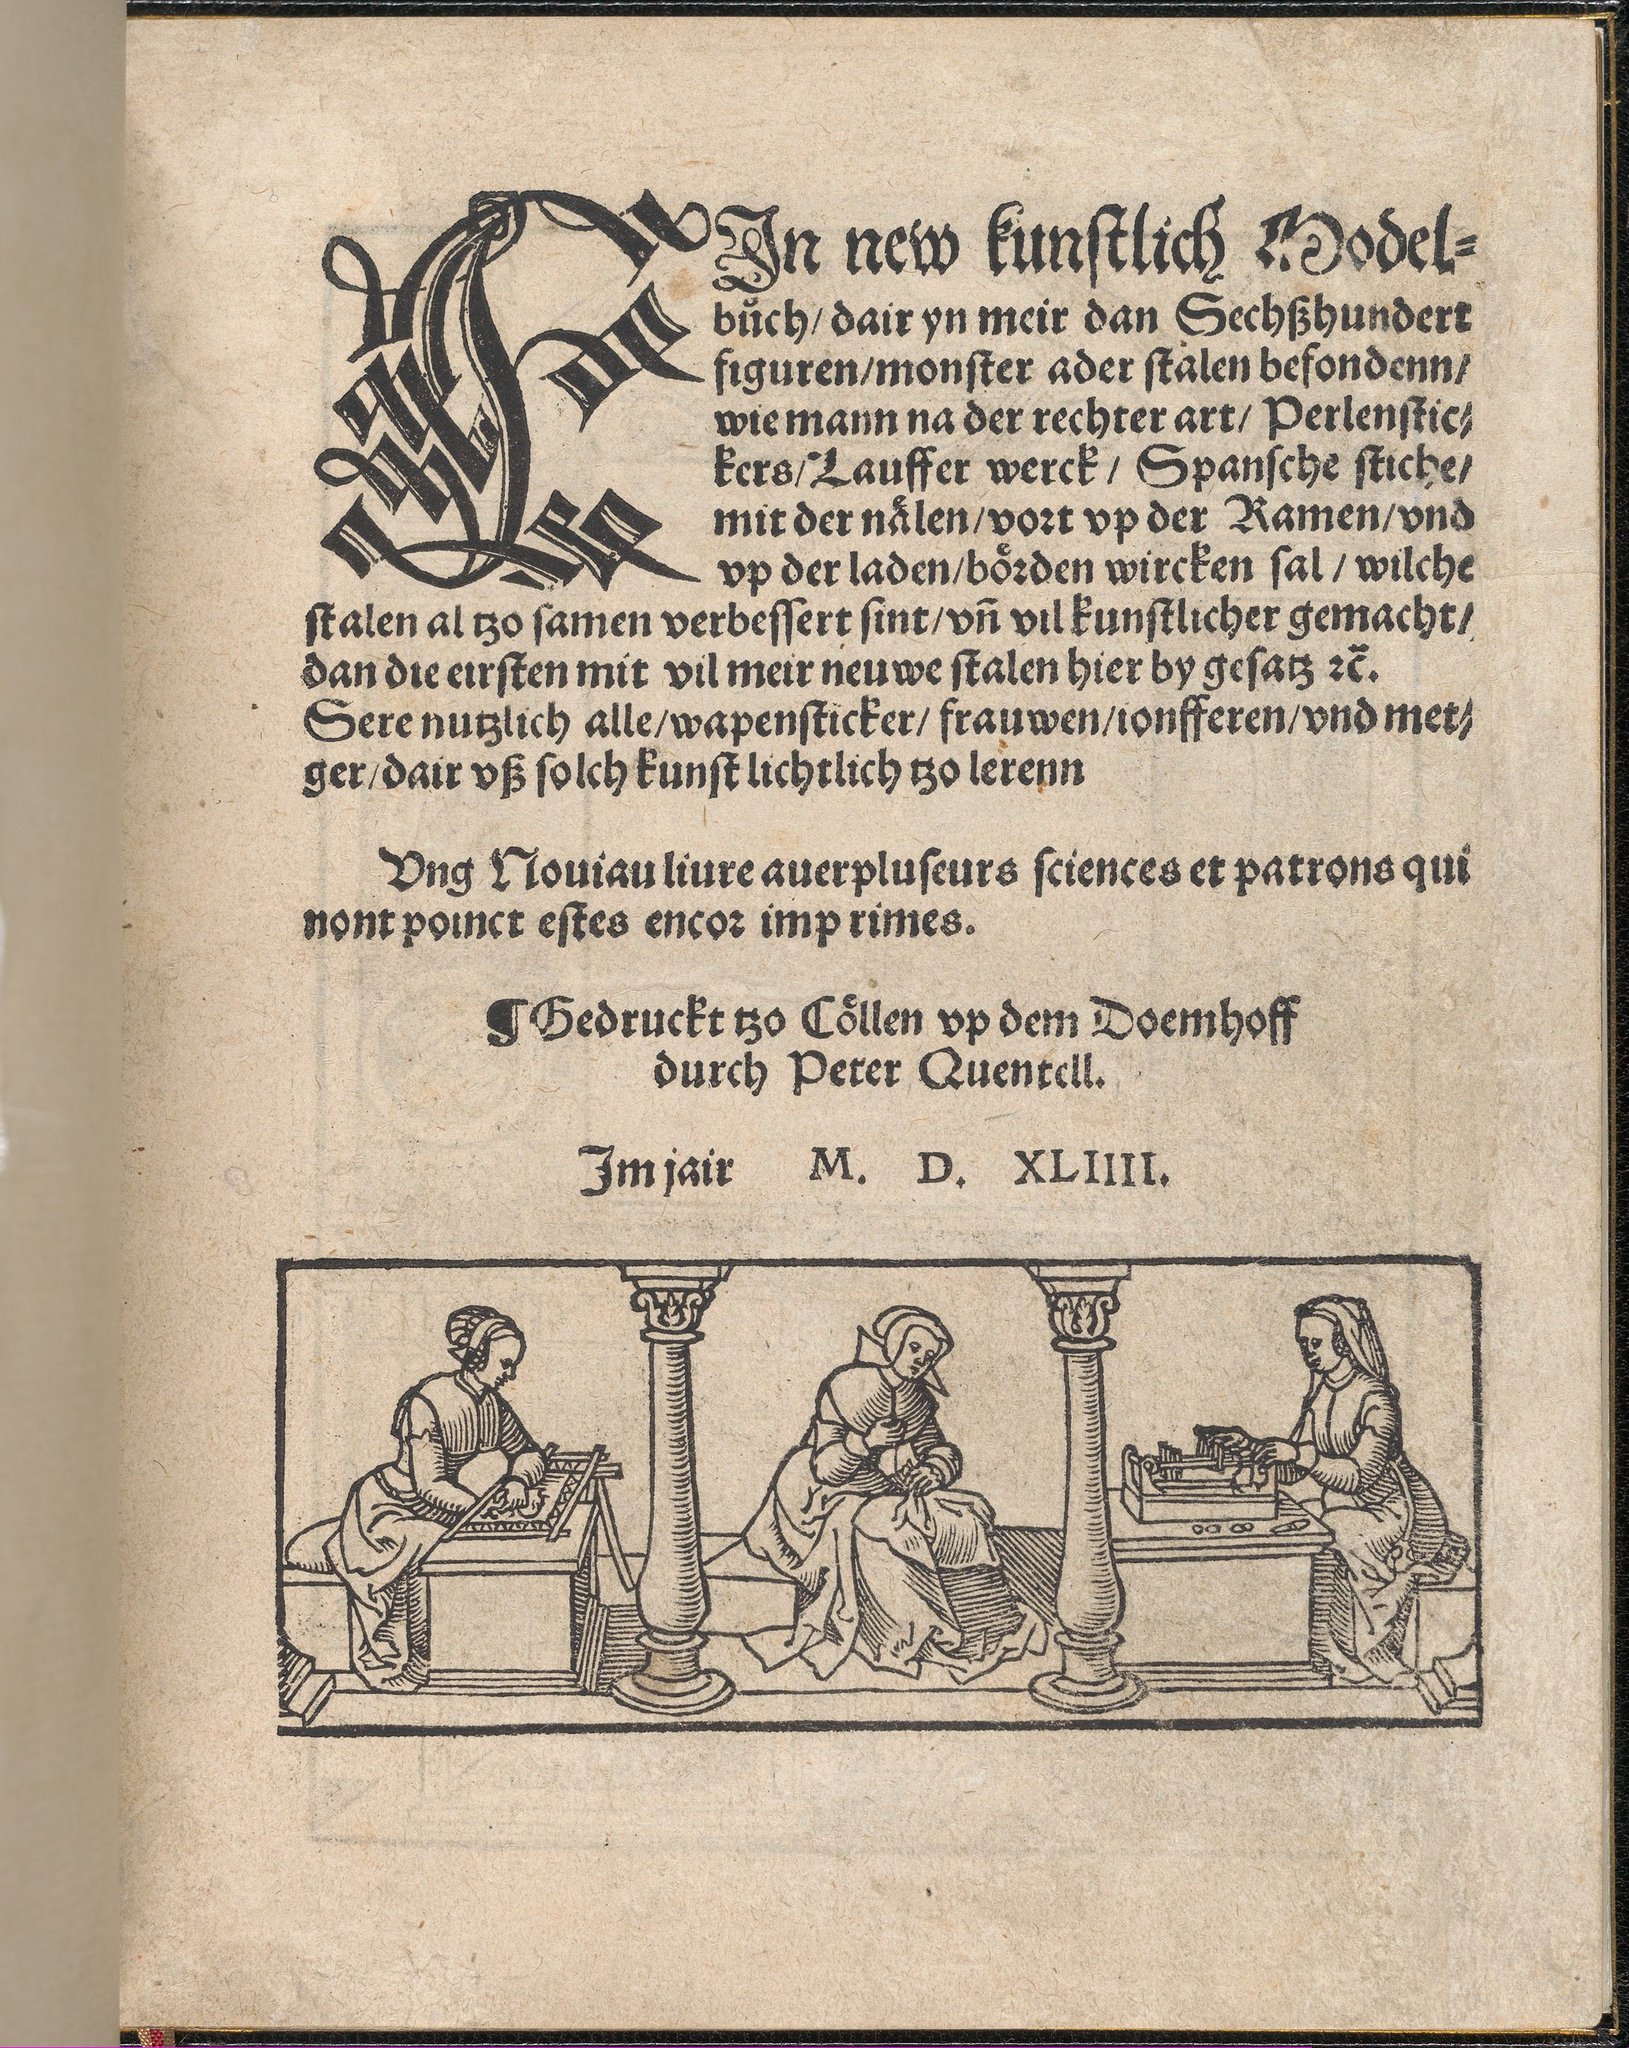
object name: book print ornament architecture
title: Ein new kunstlich Modelbuch...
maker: peter quentel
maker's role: publisher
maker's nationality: german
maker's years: 1500-1550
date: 1544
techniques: woodcut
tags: women